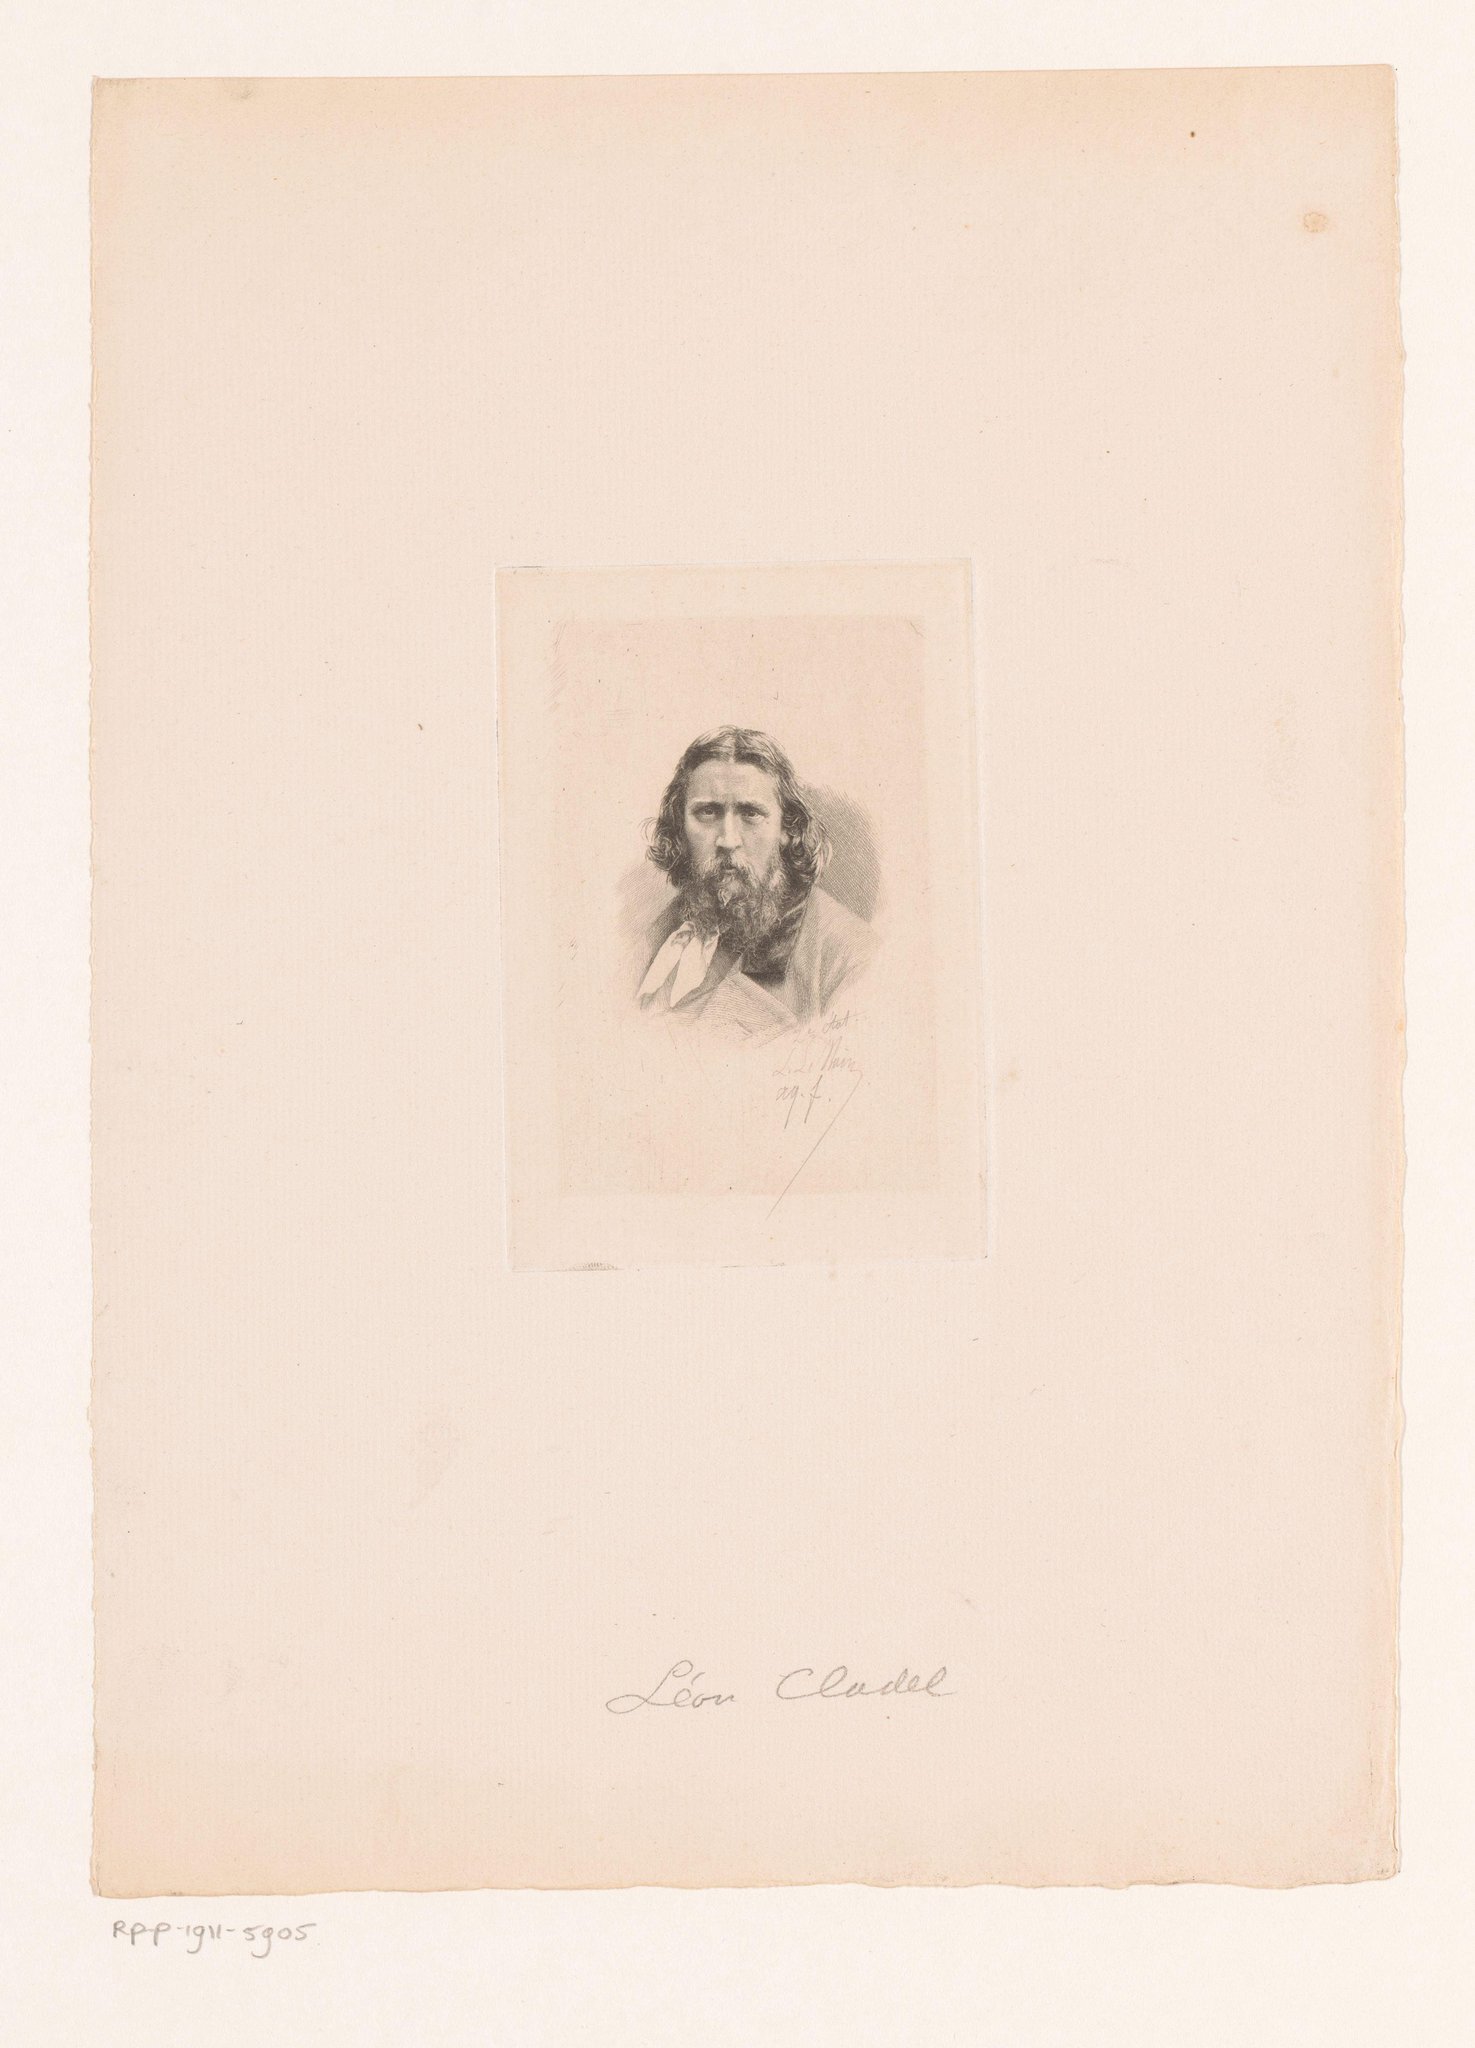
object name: print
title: Portret van Léon Cladel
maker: louis le nain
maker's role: print maker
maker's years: 1851-1939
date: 1861-1911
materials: paper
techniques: etching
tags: léon cladel, adult man, historical persons, beard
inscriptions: inscription: ‘2e état L.Le Nain aq.f.’, collector's mark: Lugt 2228